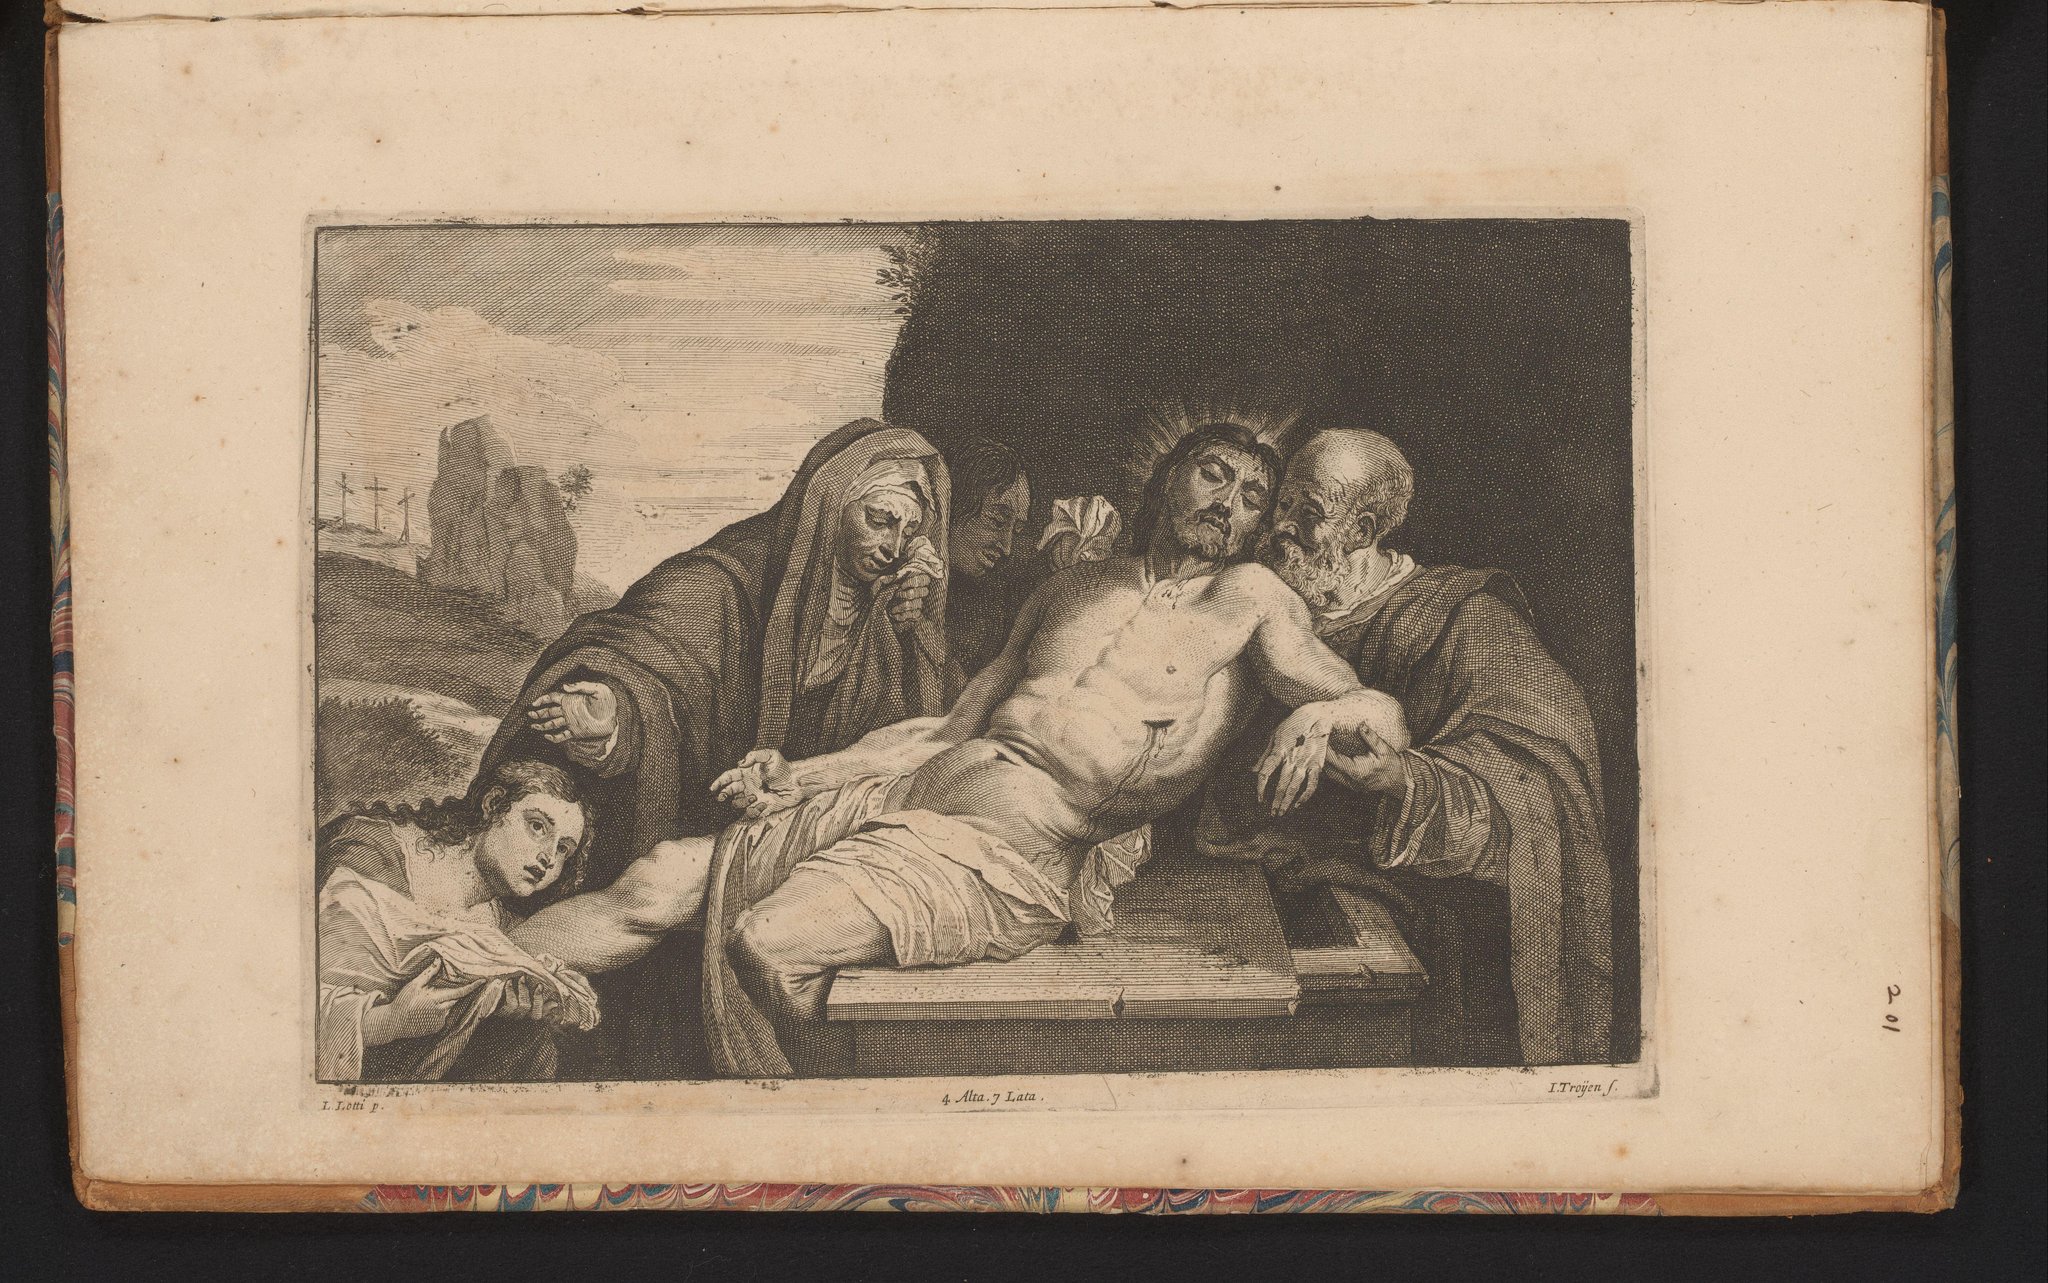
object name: album leaf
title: Bewening van Christus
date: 1660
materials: paper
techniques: engraving, etching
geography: brussels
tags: lamentation over the dead christ by his relatives and friends (christ usually without crown of thorns)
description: De prent is vervaardigd naar het schilderij van Savoldo dat zich in de collectie van het Kunsthistorisches Museum te Wenen bevindt (inventarisnummer GG_1619). David Teniers heeft waarschijnlijk van alle schilderijen uit de collectie van Leopold Willem van Oostenrijk een olieverfstudie op doek of paneel vervaardigd (zgn. pasticcio), die als voorbeeld voor de prentmakers diende. Het is niet altijd duidelijk of de pasticci door hem zijn gemaakt of door zijn atelier. Niet alle pasticci zijn overgeleverd.